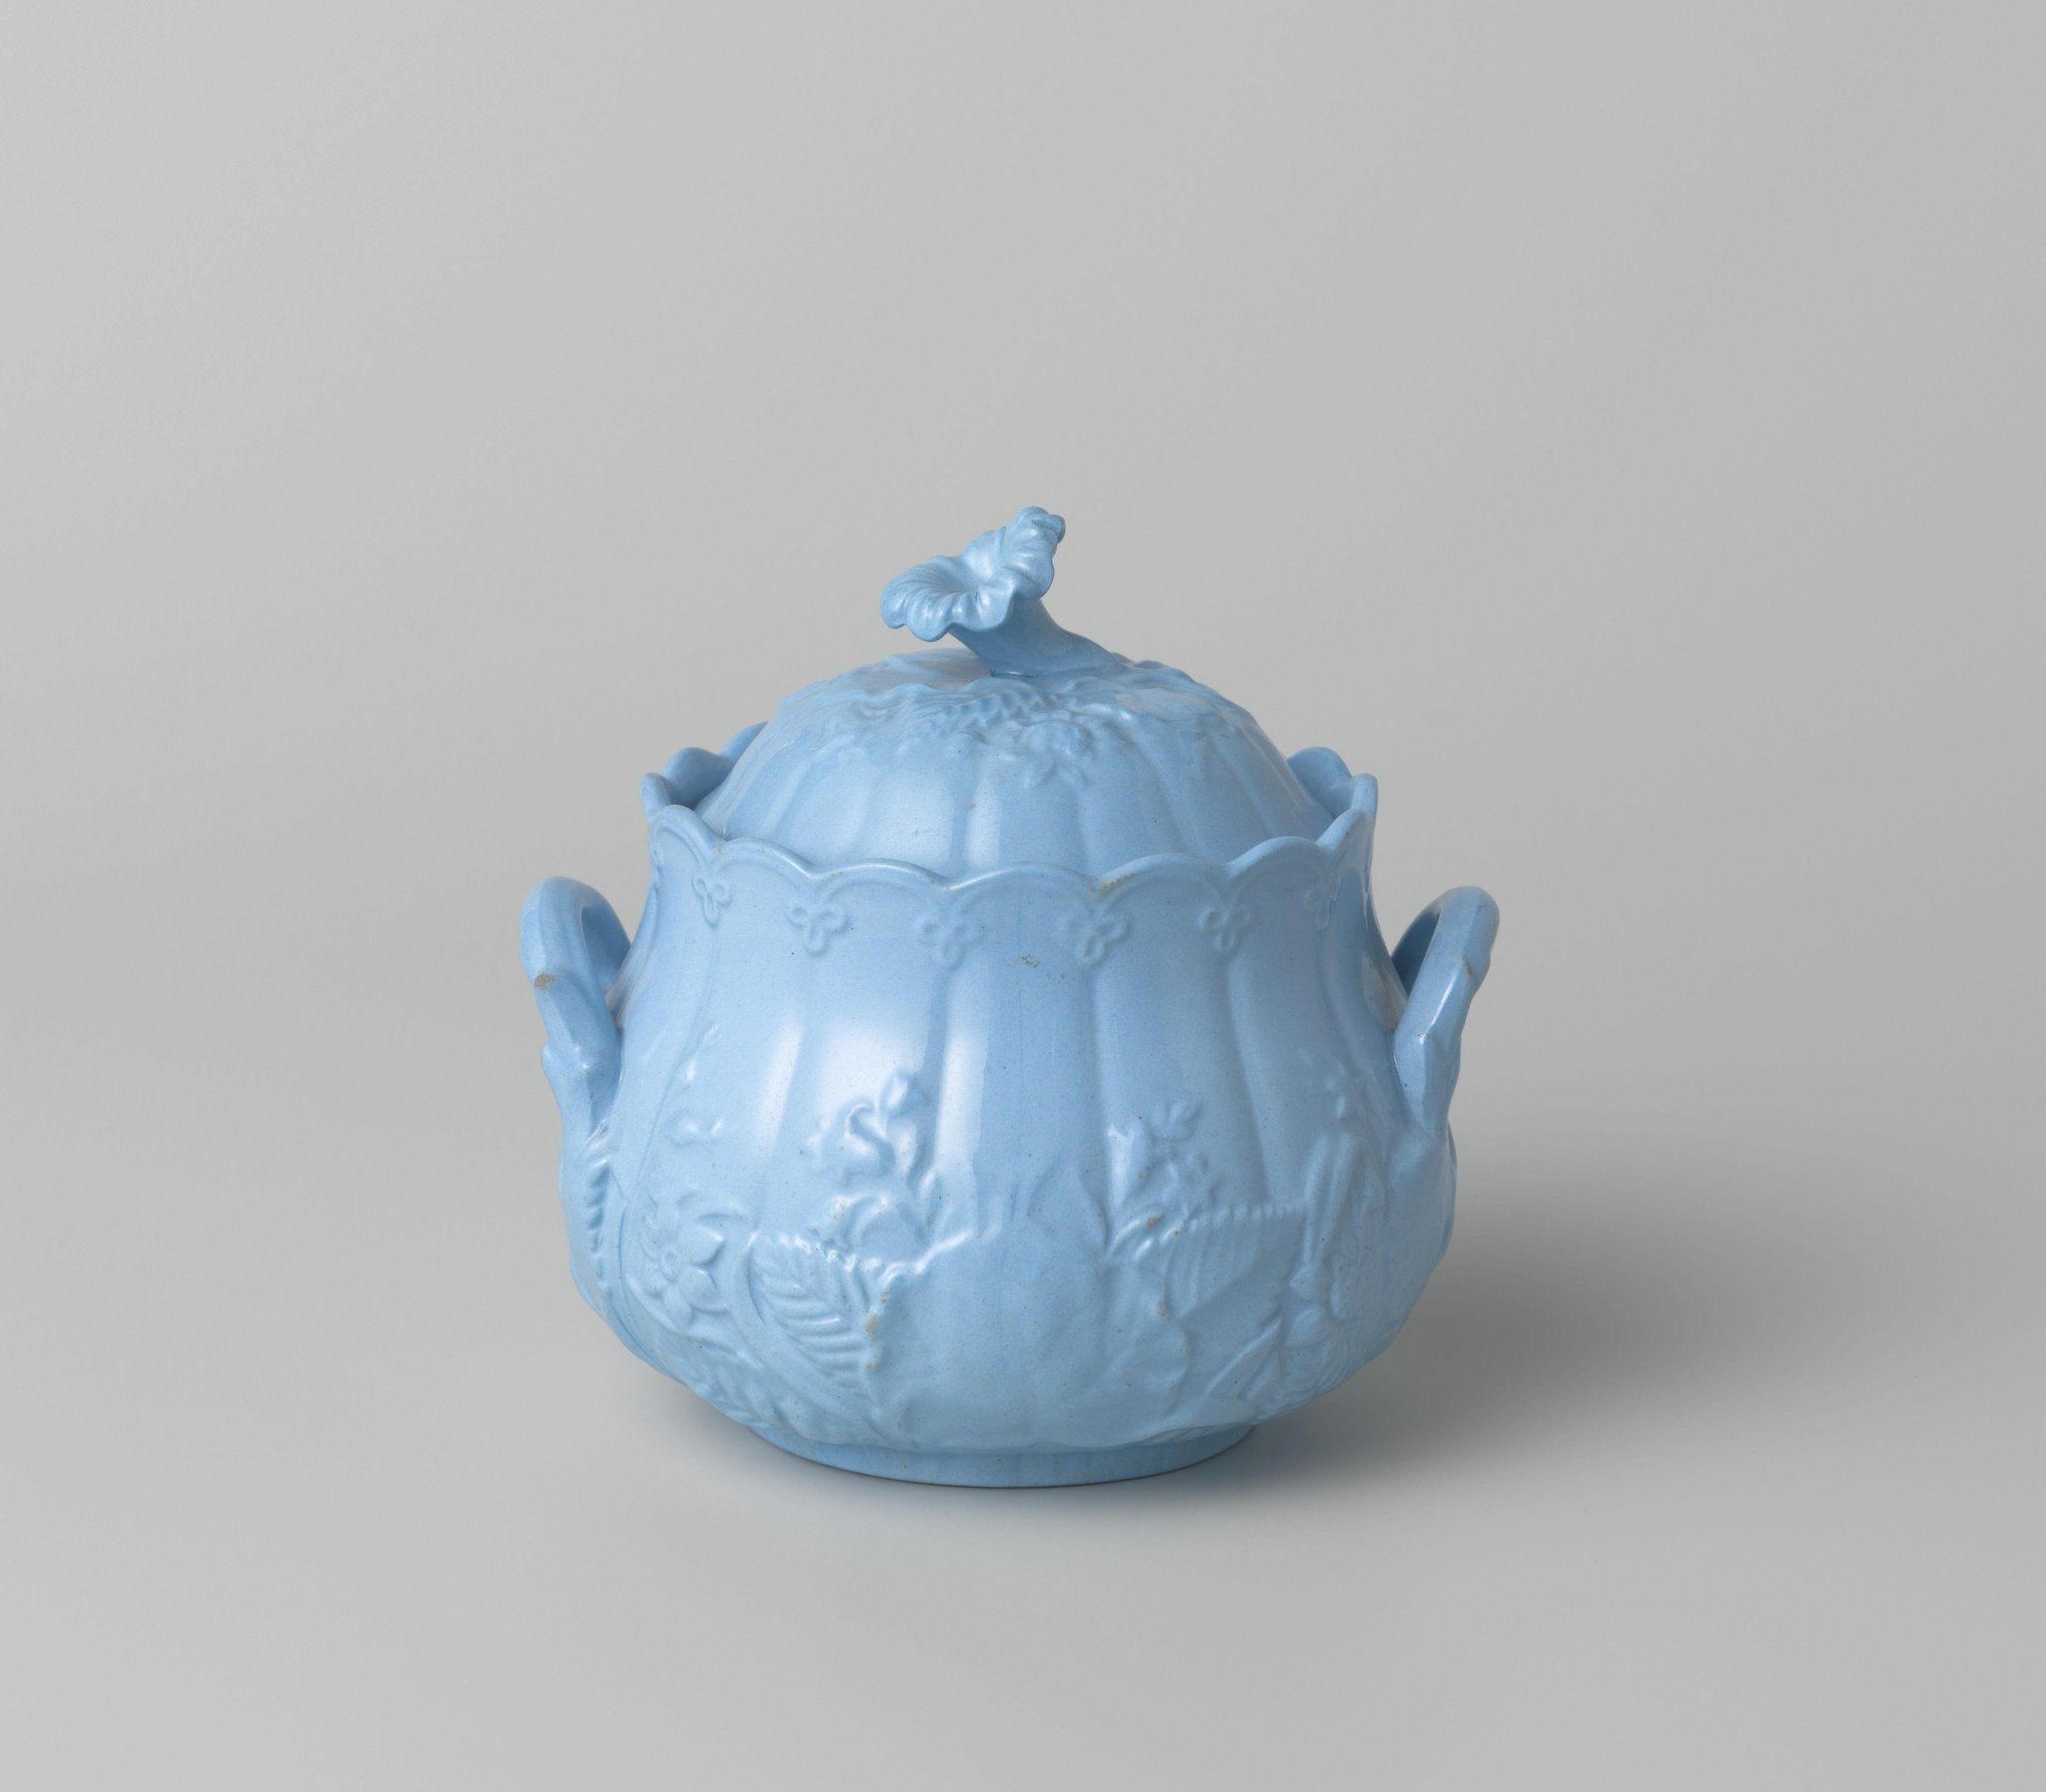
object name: sugar box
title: Suikerpot met deksel, blauw, met bloemen en bladeren in reliëf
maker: petrus regout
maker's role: plateelbakker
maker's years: 1801-1879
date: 1860-1890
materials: stoneware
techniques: engels steengoed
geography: maastricht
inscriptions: mark: ‘P. REGOUT // MAASTRICHT // 21’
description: Suikerpot met deksel van aardewerk, blauwsteen. De buitenzijde met bloemen en bladeren in reliëf. De twee handvatten opgebouwd uit bladeren en twijgen. Het deksel met een reliëf van bladeren en bloemen, de dekselknop in de vorm van een kelkbloem.